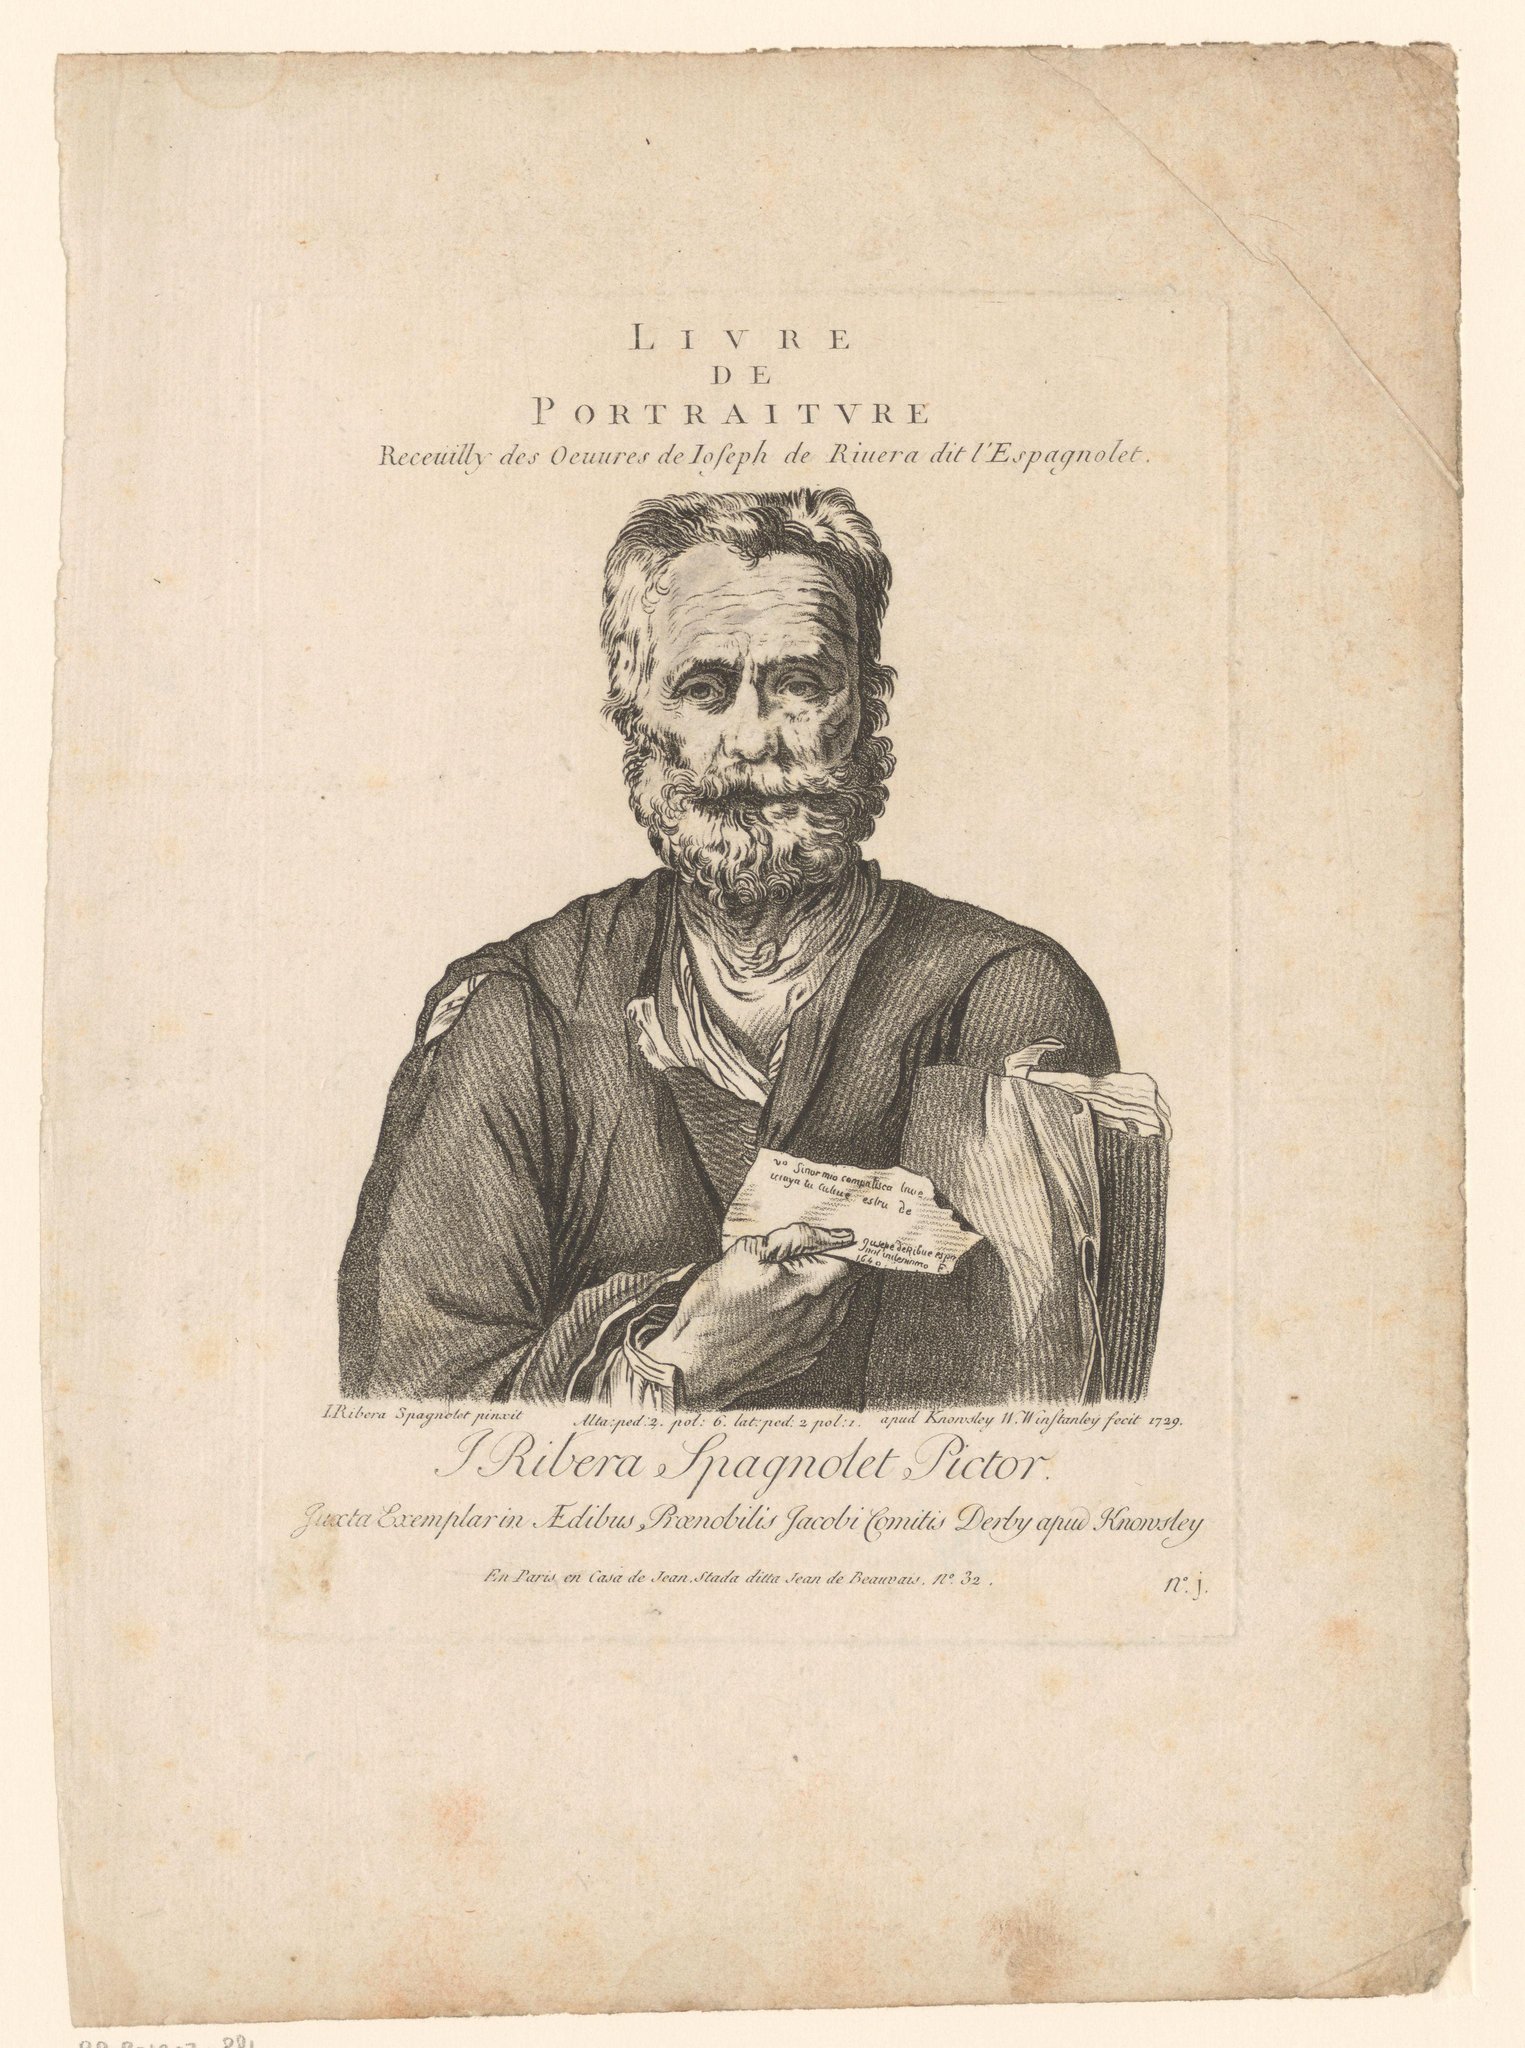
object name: print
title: Portret van Jusepe de Ribera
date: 1729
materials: paper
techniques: etching, roulette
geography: knowsley hall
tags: naples, painter, draughtsman, jusepe de ribera, historical persons, portrait, self-portrait of painter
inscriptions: collector's mark: Lugt 2228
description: Boven het portret staat 'Livre de Portraiture Receuilly des Oeuvres de Ioseph de Rivera dit l'Espagnolet'. De prent is mogelijk een titelpagina voor een publicatie met deze naam. Een mogelijk eerdere of latere staat, zonder adres van de uitgever en de naam van de publicatie, bevindt zich in het British Museum. Het kan ook zijn dat het hier niet gaat om een andere staat, maar een andere prent.